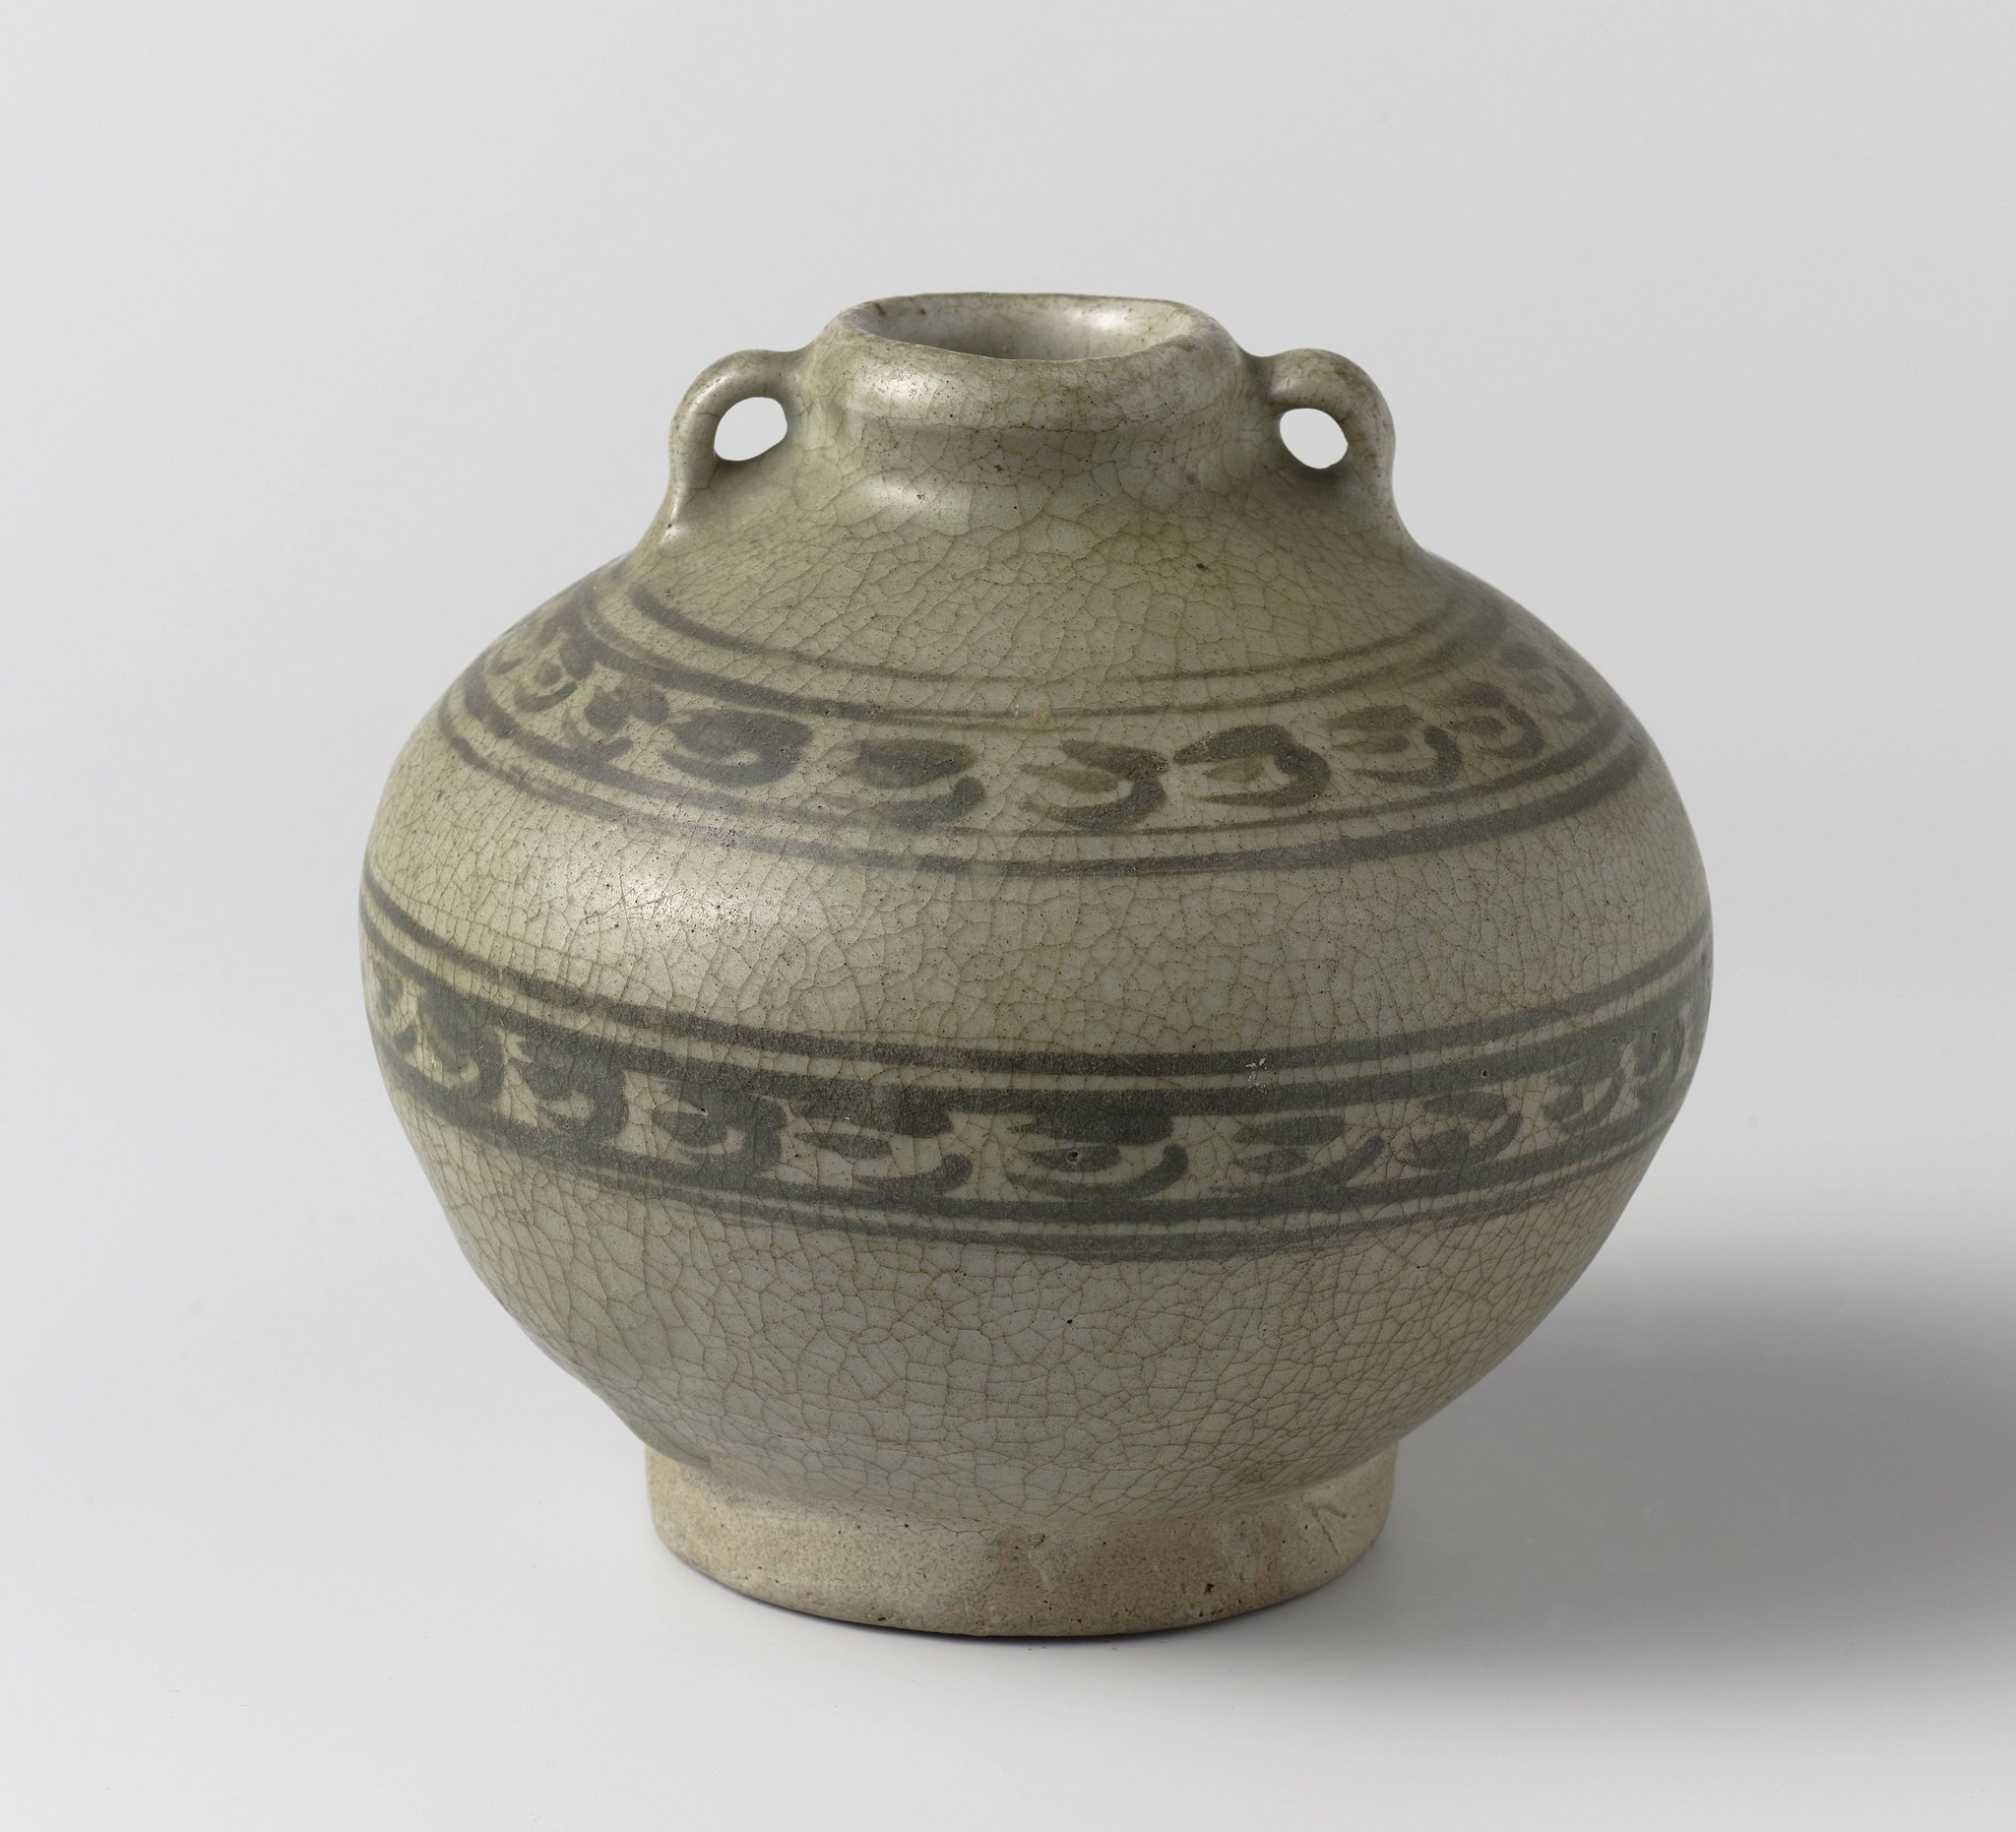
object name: pot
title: Jar with two ornamental borders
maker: Anonymous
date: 1300-1599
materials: glaze, stoneware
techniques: firing, turning, vitrification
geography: thailand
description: Pot van steengoed met een bolvormig lichaam en een smalle, korte nek, beschilderd onder het glazuur in zwart en bedekt met een groen glazuur. Op de buik en de schouder een decoratieve band. Vanuit de schouder twee halfronde oren bevestigd aan de nek. Het onderste deel van de pot is ongeglazuurd. Celadon.